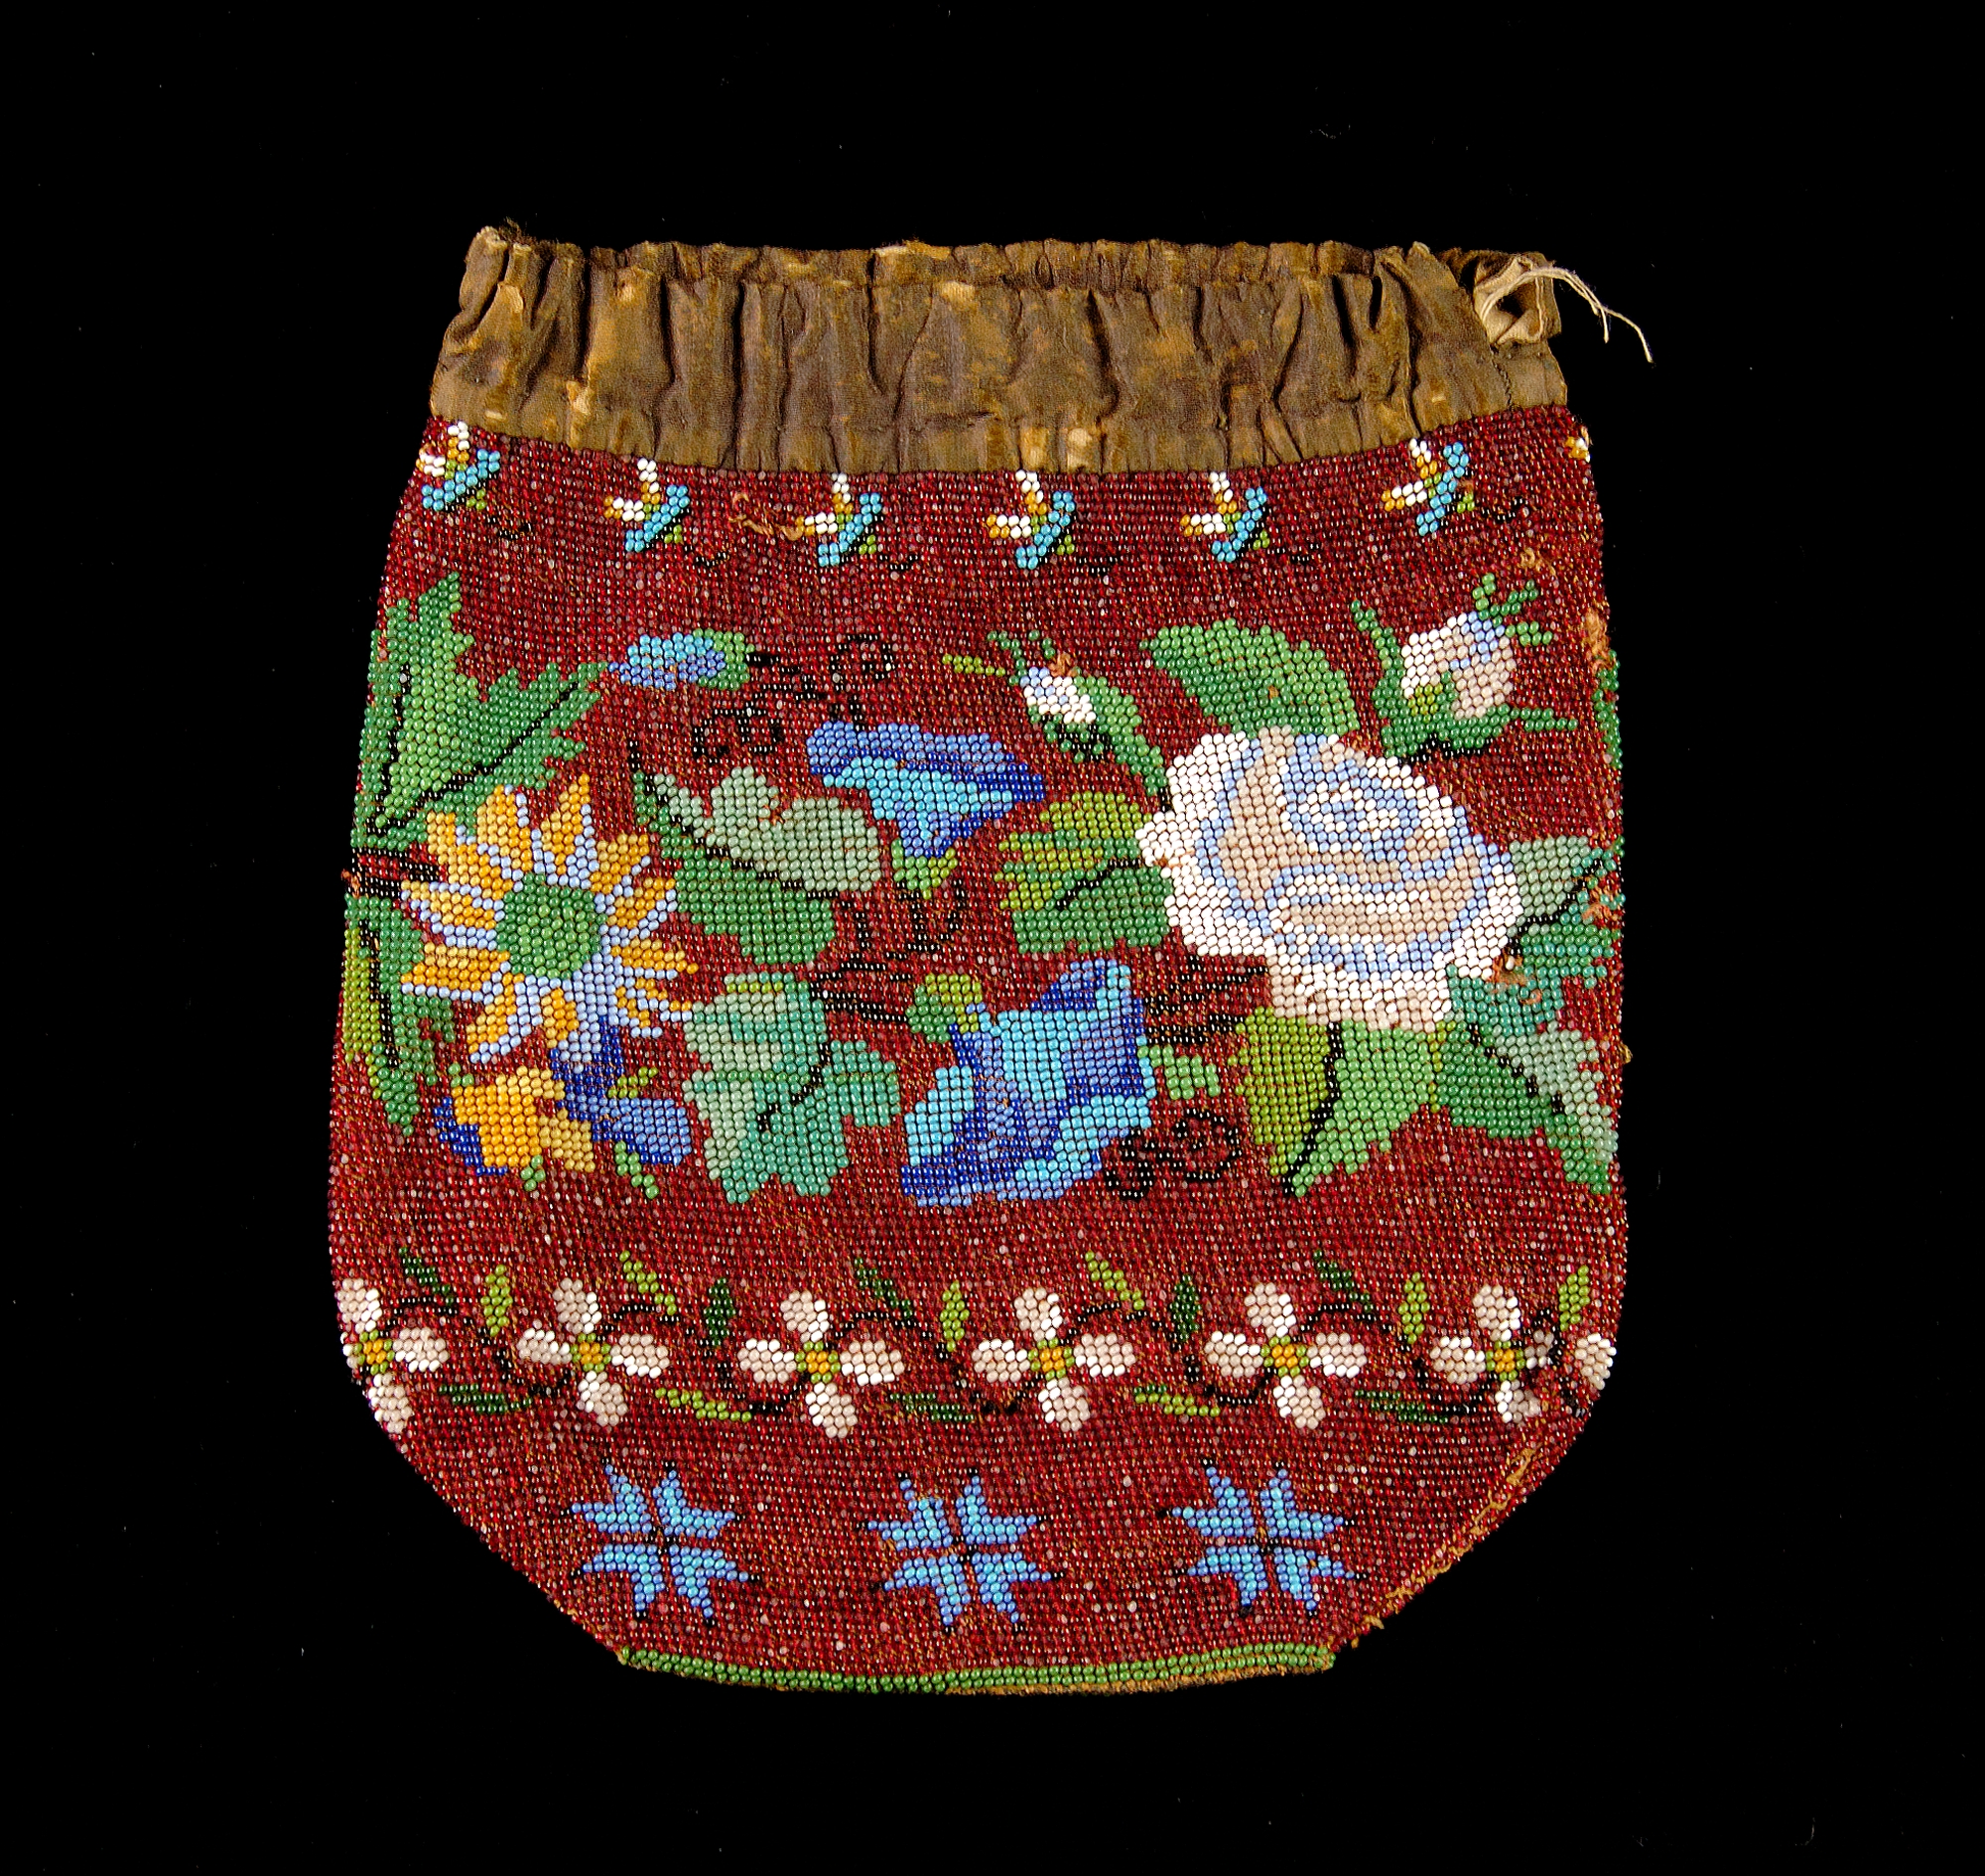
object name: pouch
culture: american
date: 1830-1860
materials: cotton, glass, linen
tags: flowers